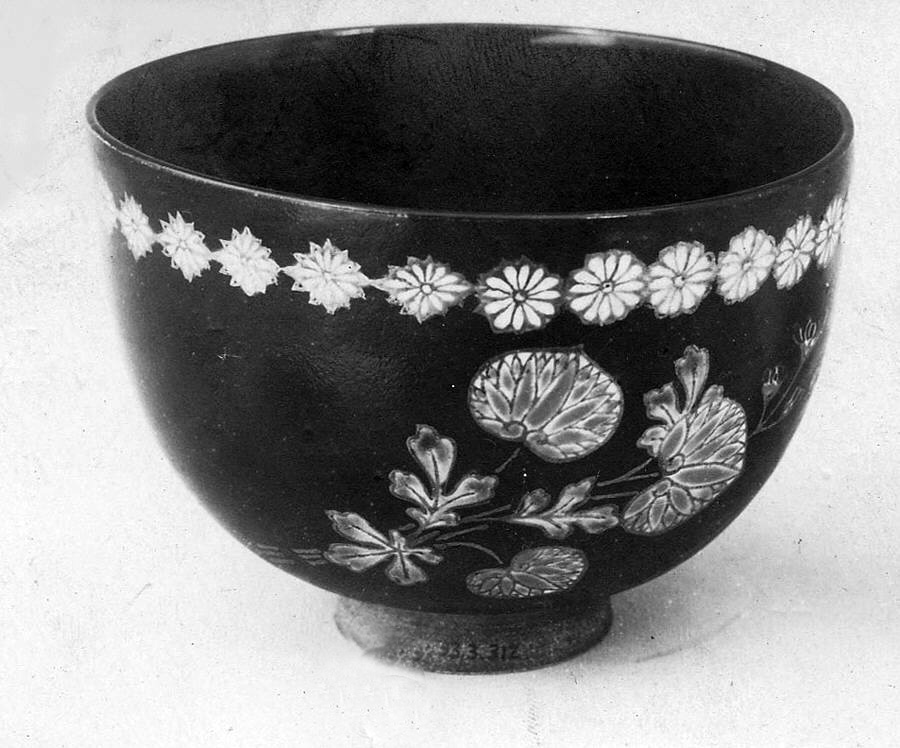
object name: teabowl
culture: japanese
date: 1670-1790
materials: glaze, pottery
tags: flowers